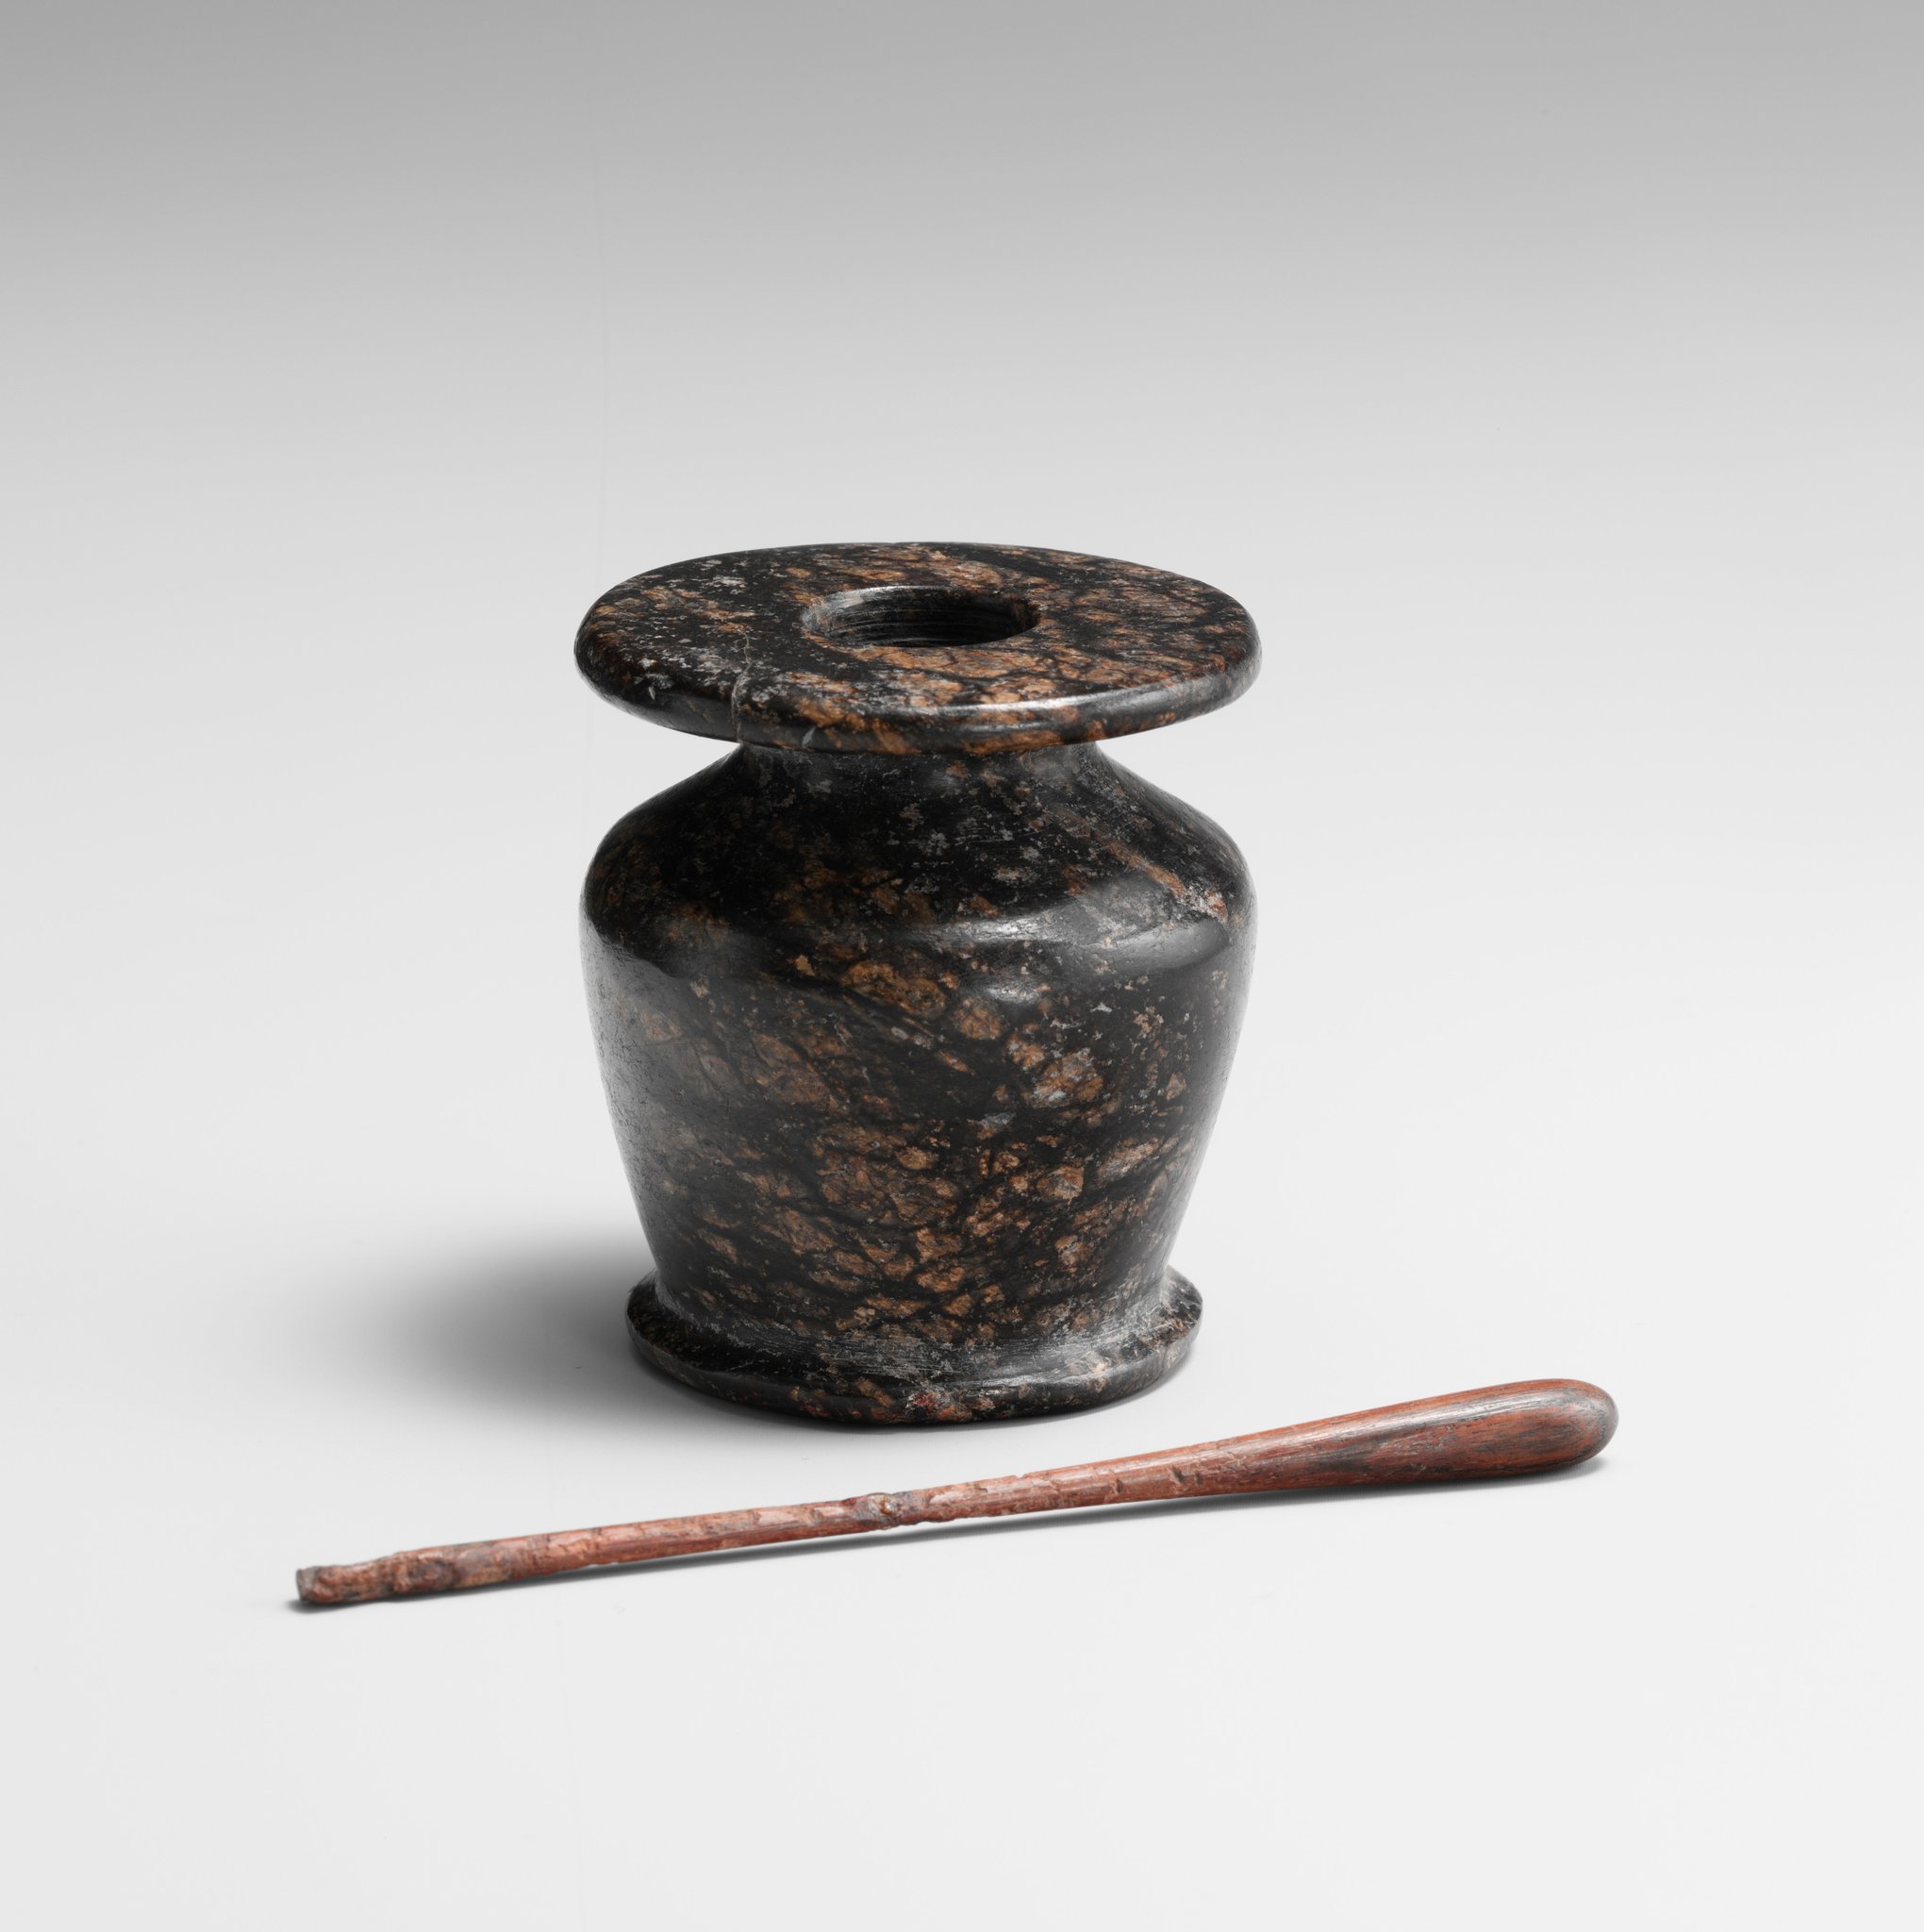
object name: kohl stick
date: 1492-1473 BCE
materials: wood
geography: egypt